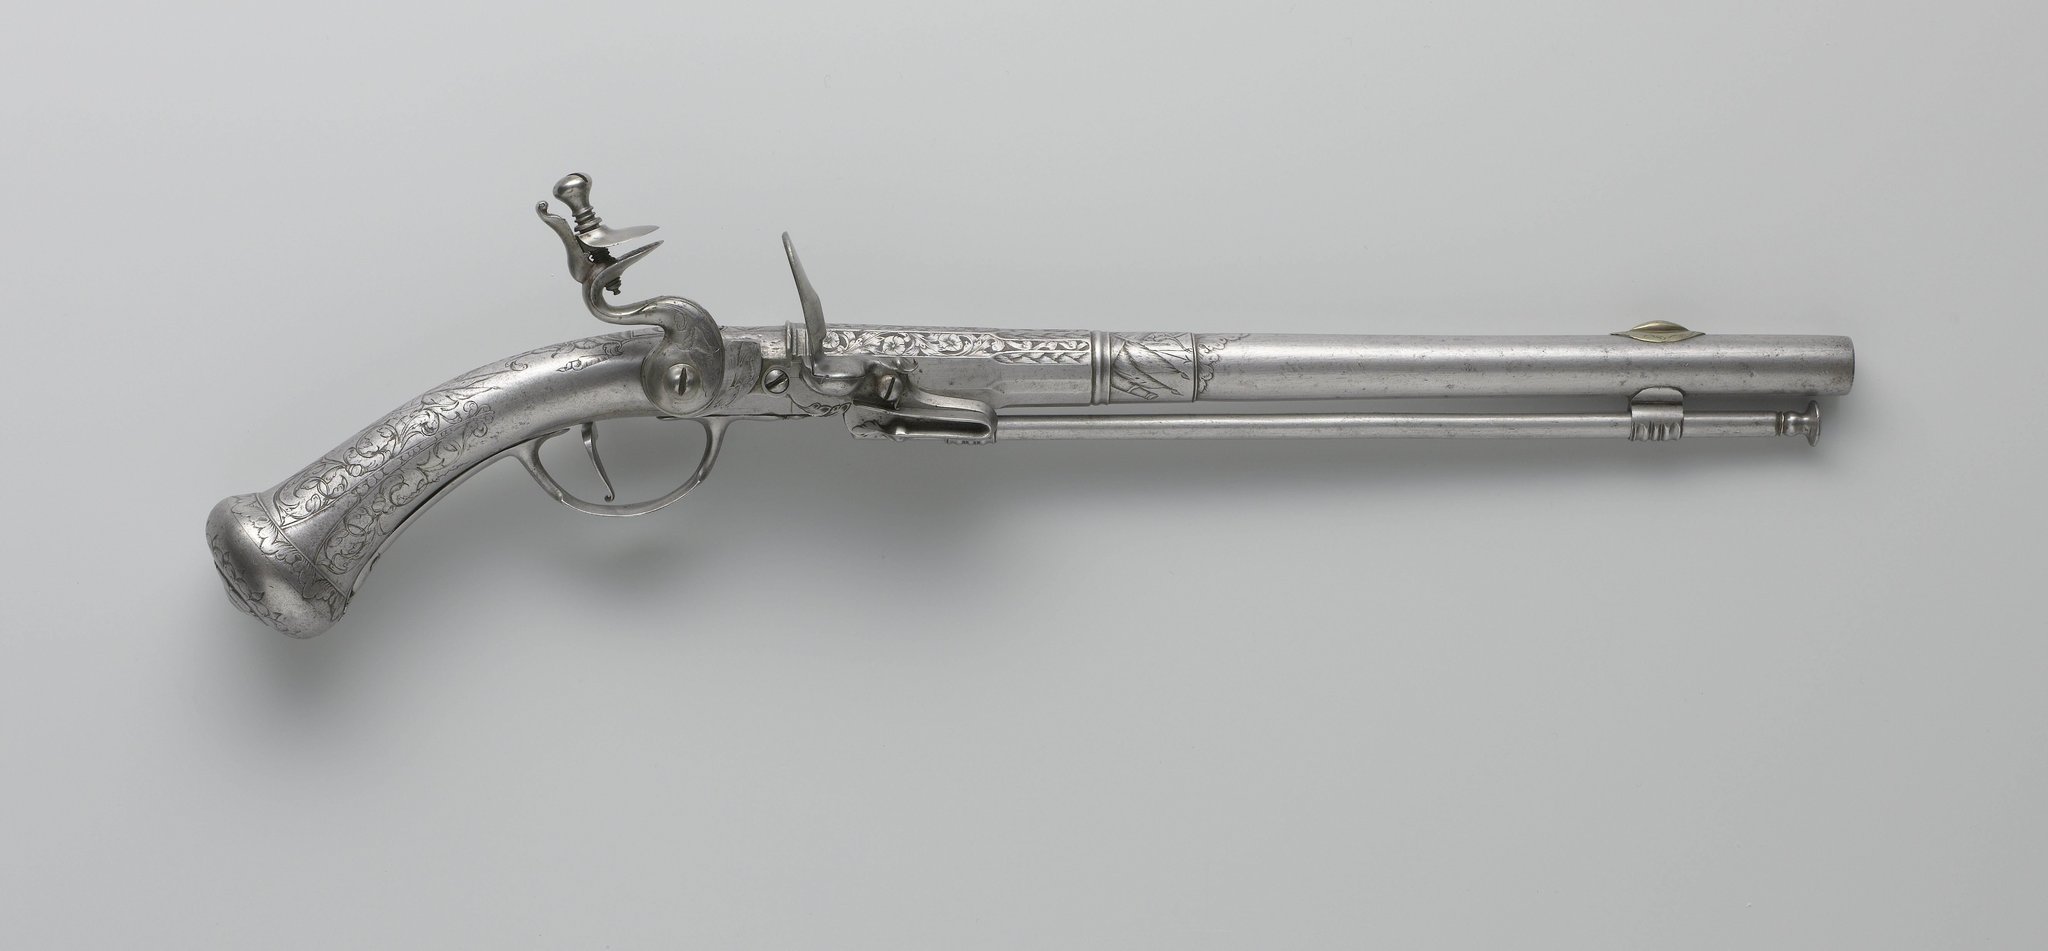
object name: flintlock pistol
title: vuursteenpistool met ijzeren kolf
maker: Anonymous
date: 1660-1670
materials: brass, iron, steel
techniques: engraving, relief, soldering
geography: maastricht